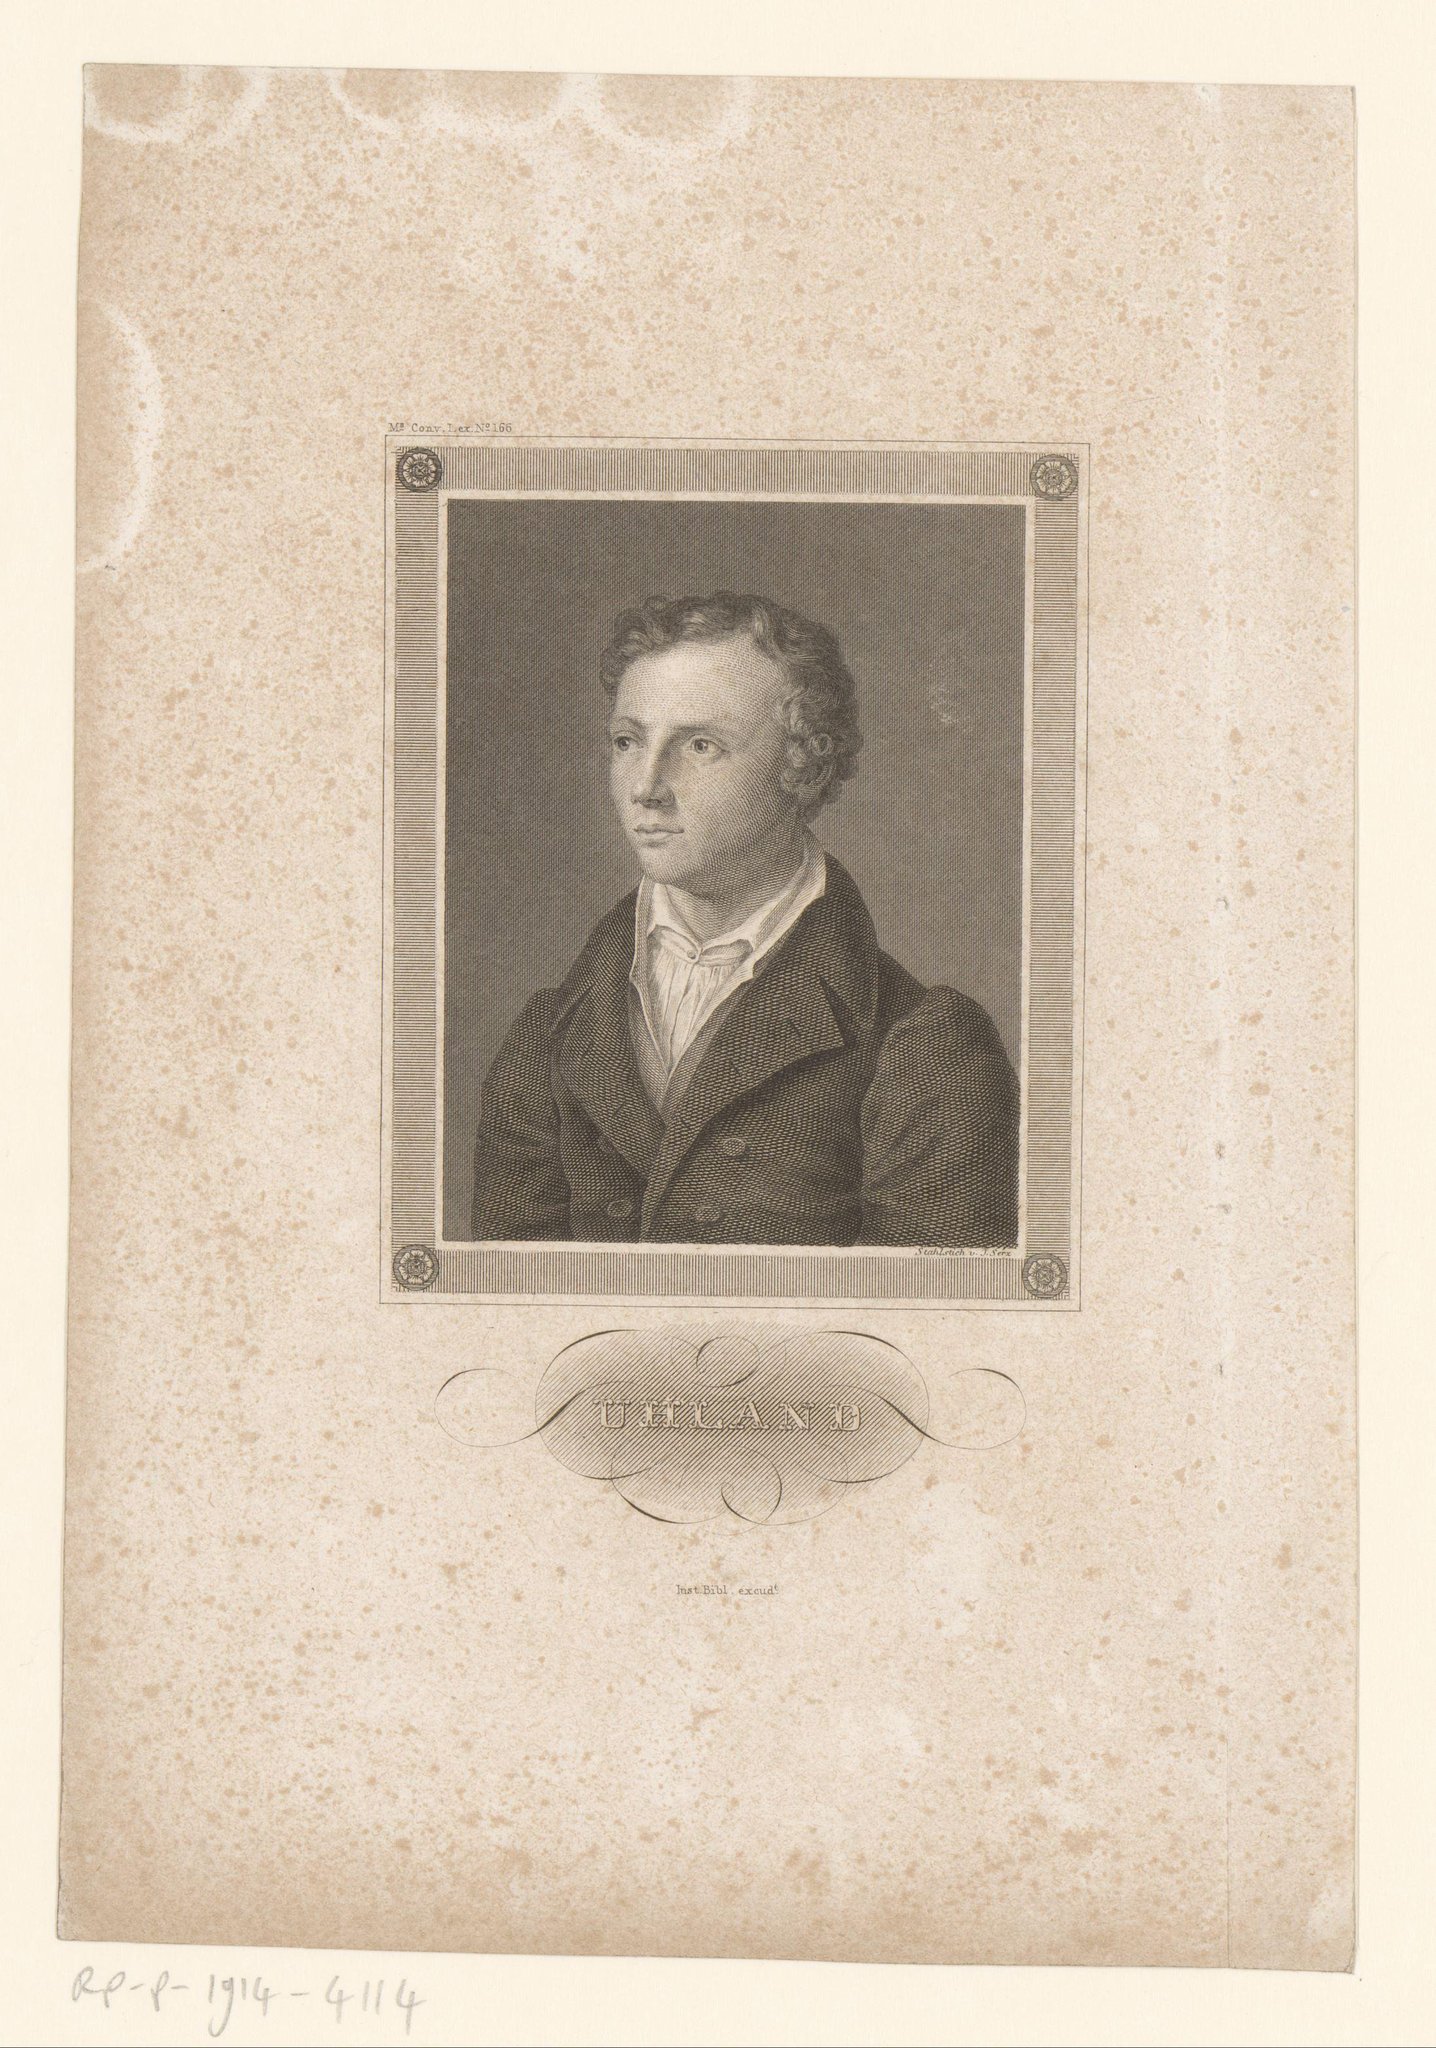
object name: book illustration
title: Portret van Ludwig Uhland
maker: johann georg serz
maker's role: print maker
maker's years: 1808-1878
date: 1840-1855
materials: paper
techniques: engraving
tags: historical persons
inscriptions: collector's mark: Lugt 2228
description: Prent afkomstig uit: Conversations-Lexikon für die gebildeten Stände, voor het eerst uitgegeven tussen 1840-1855.